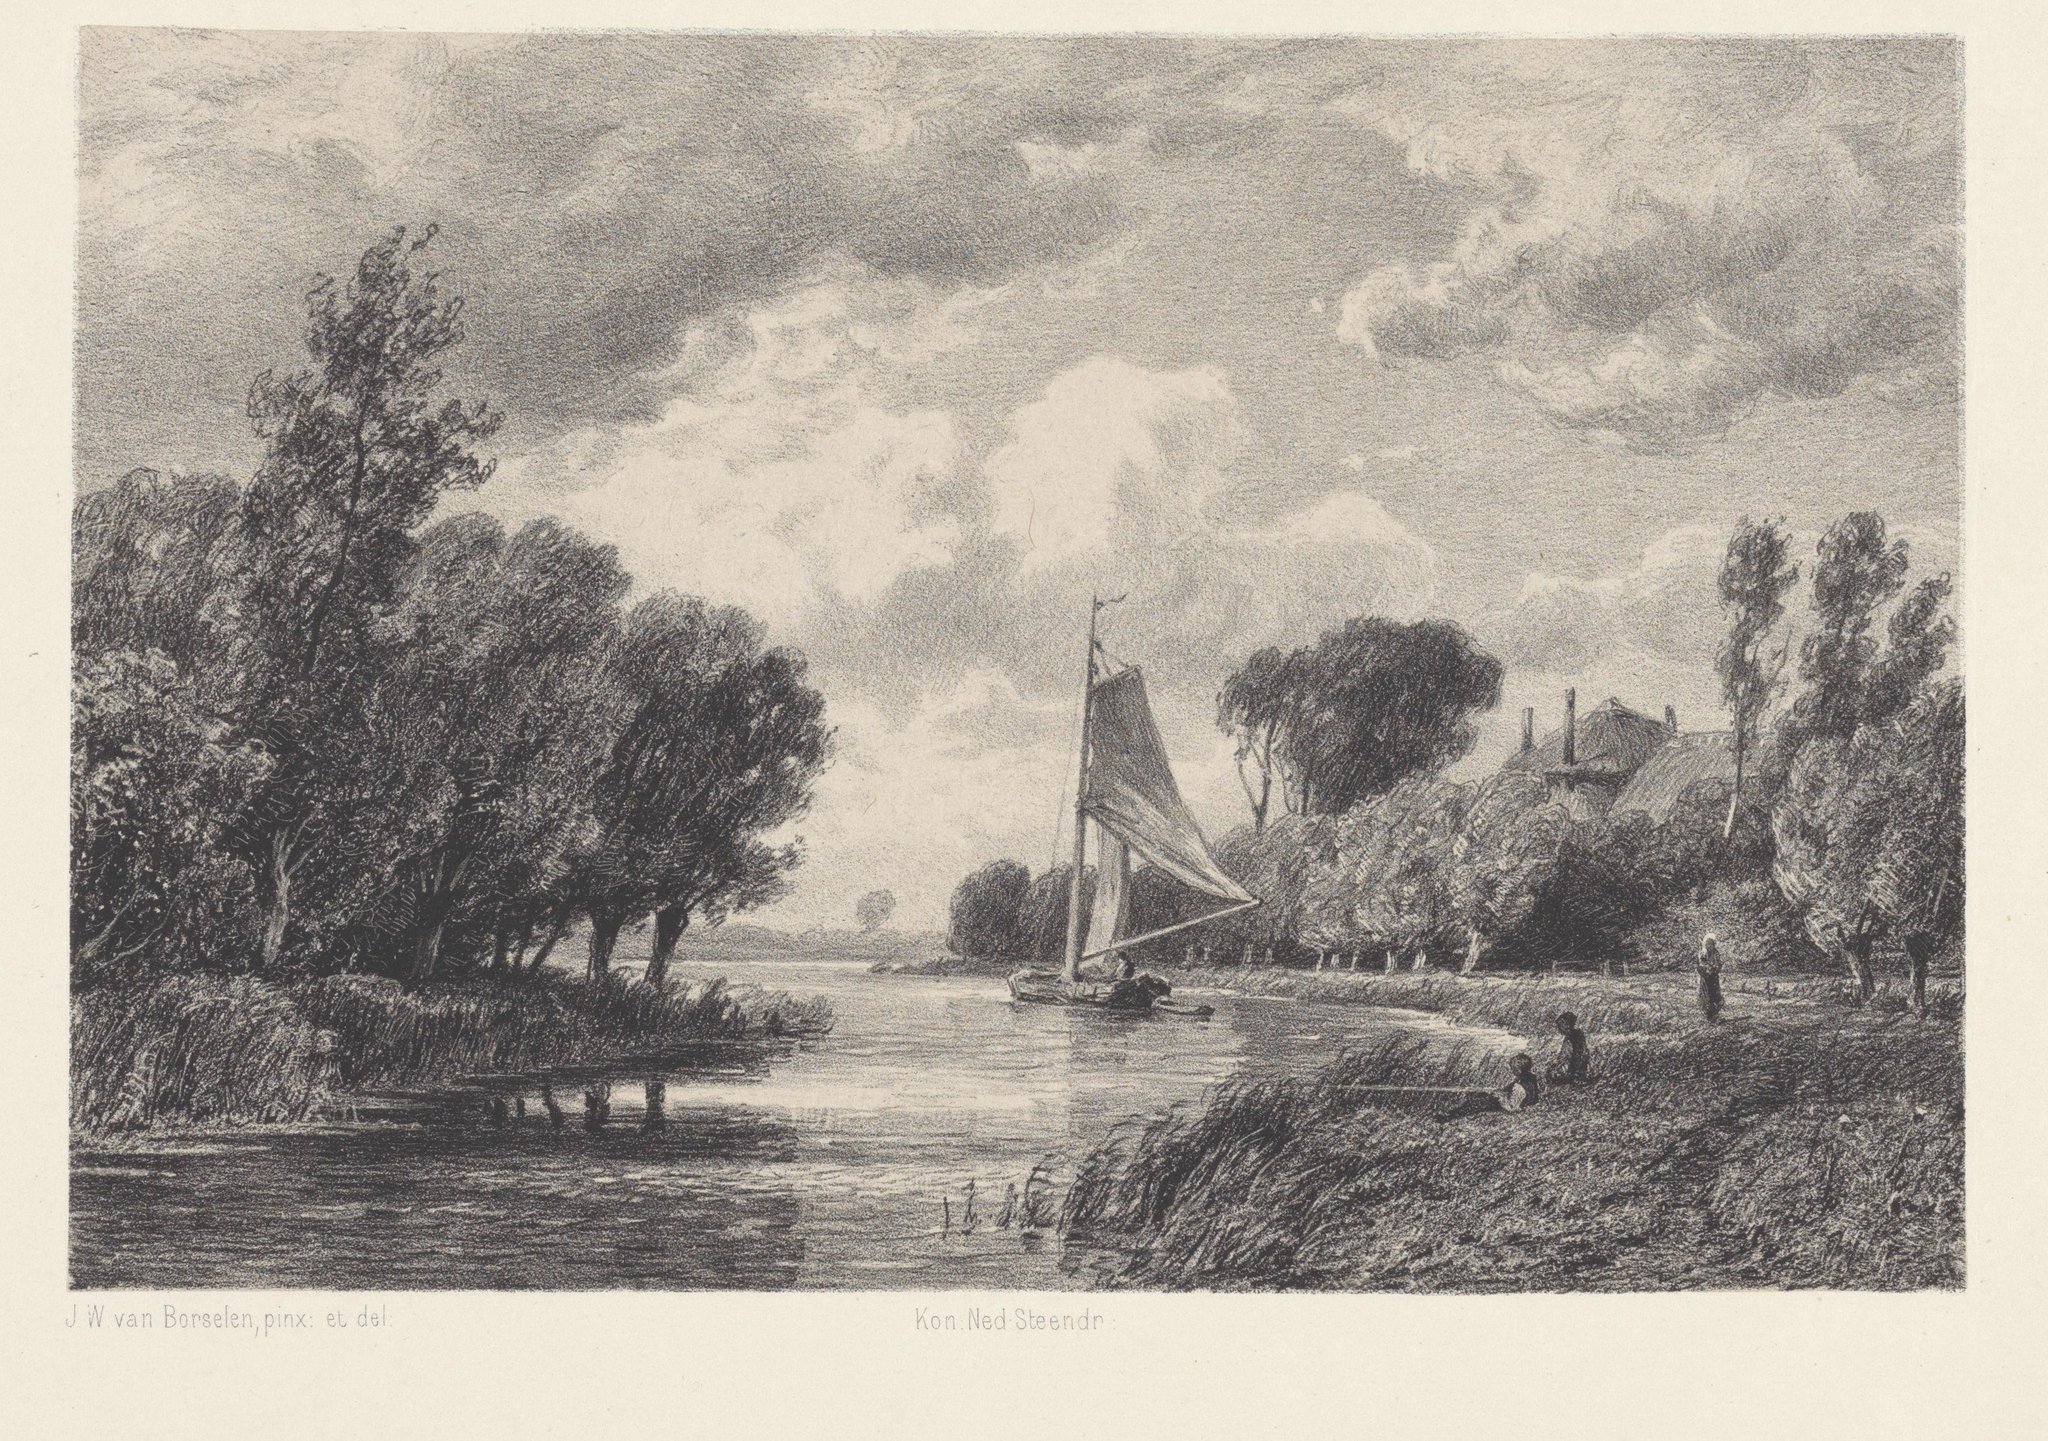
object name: print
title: Rivierlandschap met zeilboot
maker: jan willem van borselen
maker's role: draughtsman, print maker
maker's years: 1825-1892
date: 1867-1874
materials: paper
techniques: tone lithography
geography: netherlands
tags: sailing-ship, sailing-boat, river (+ landscape with figures, staffage), fisherman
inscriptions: collector's mark: Lugt 2228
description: Op de linkeroever van de rivier staan bomen, op de rechteroever een boerderij met een hooischuur. Aan de kant zitten twee figuren waaronder een visser. In het midden, op het water, vaart een zeilboot.